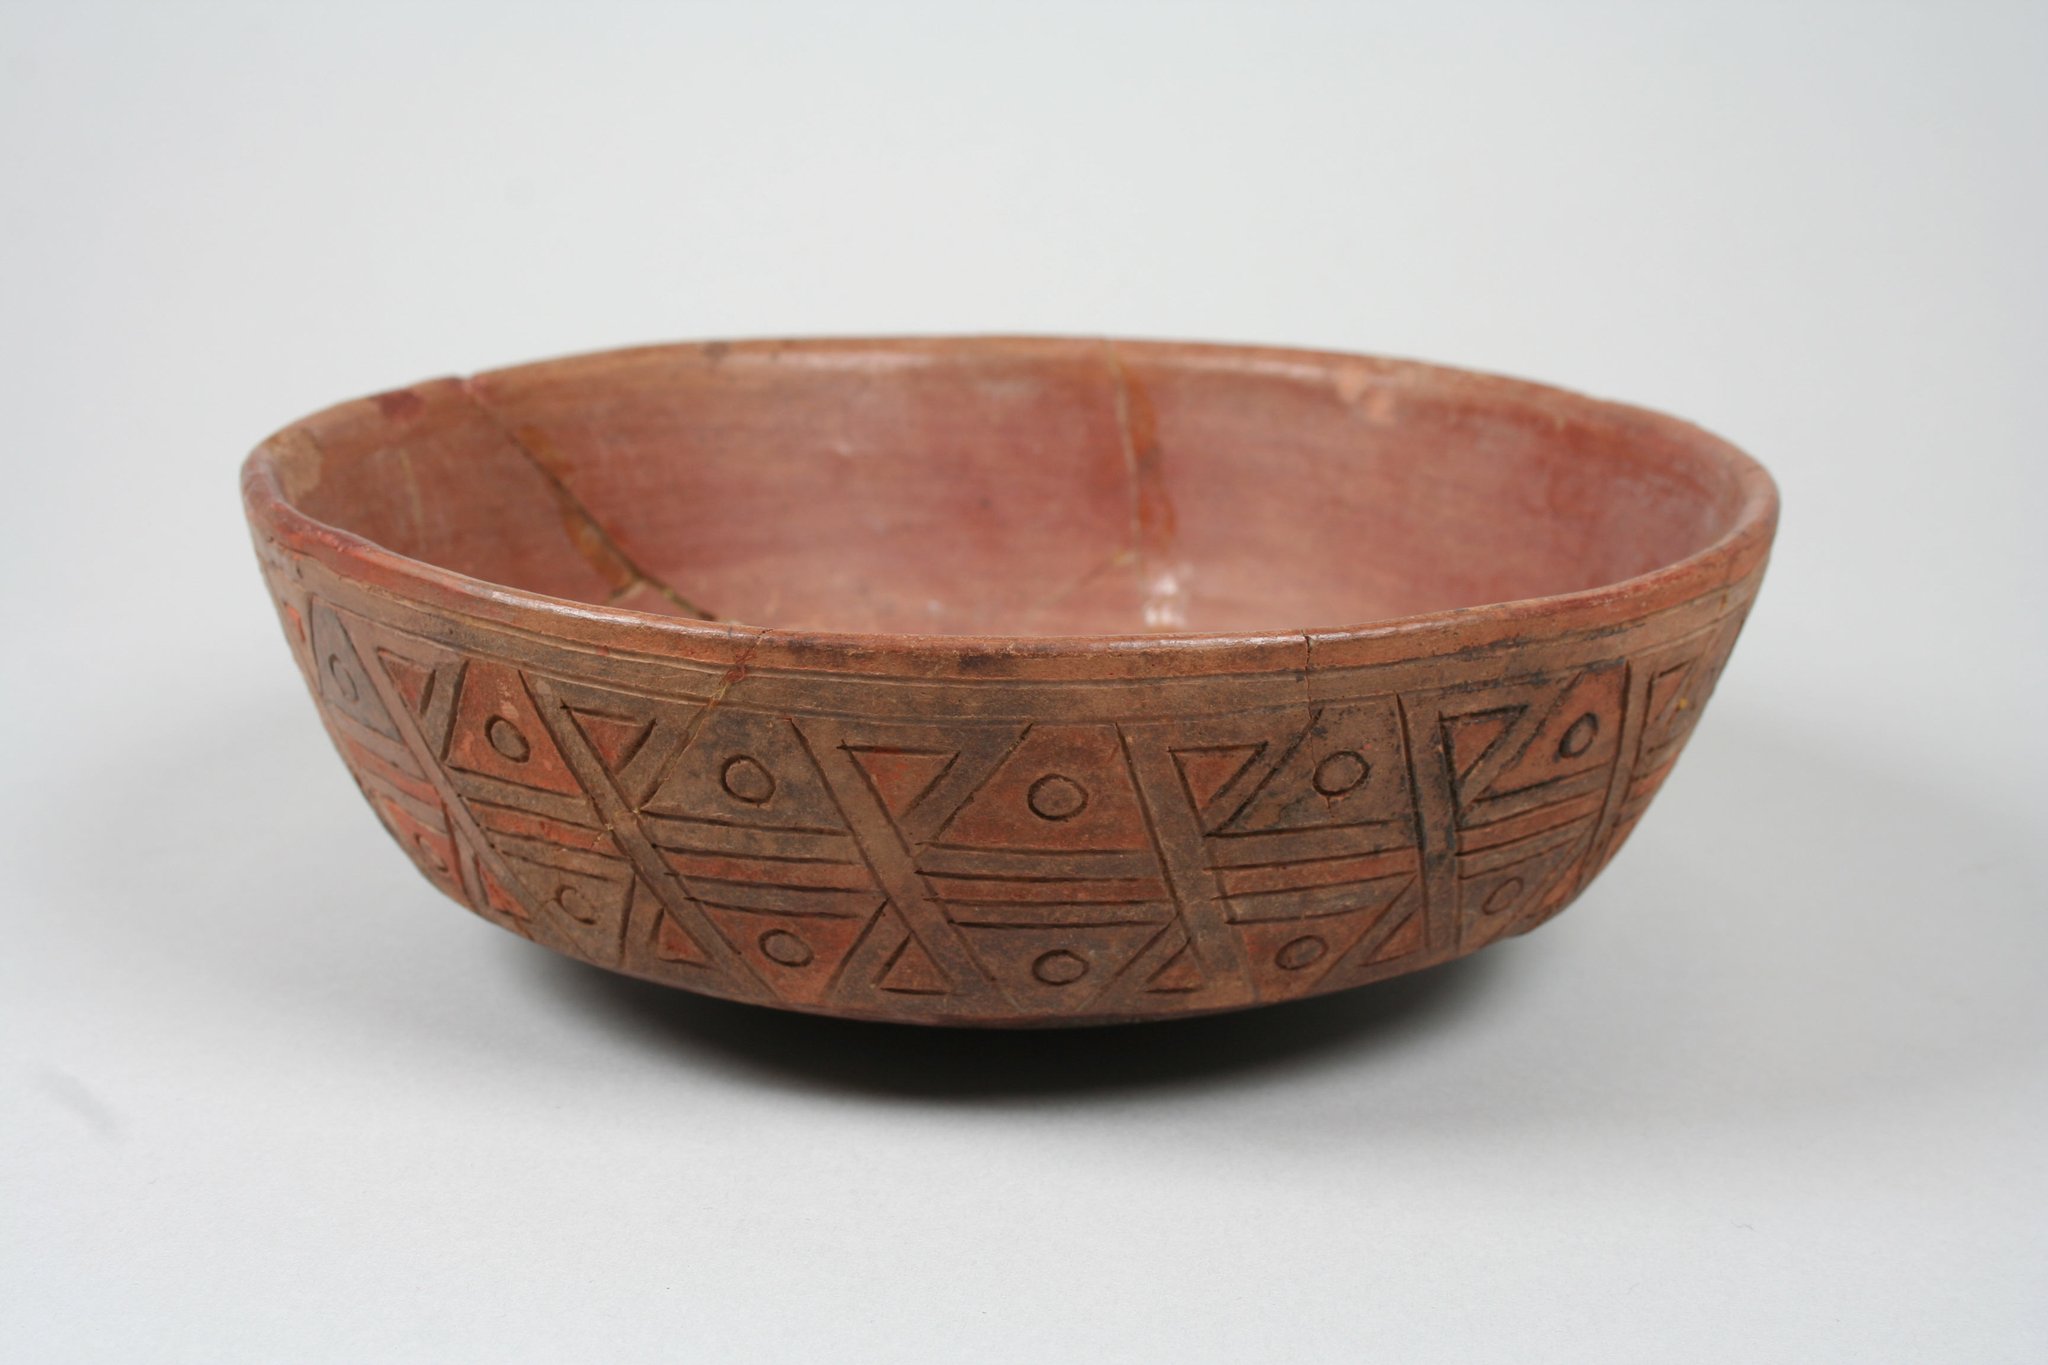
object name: bowl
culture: paracas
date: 500-201 BCE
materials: ceramic, pigment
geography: peru